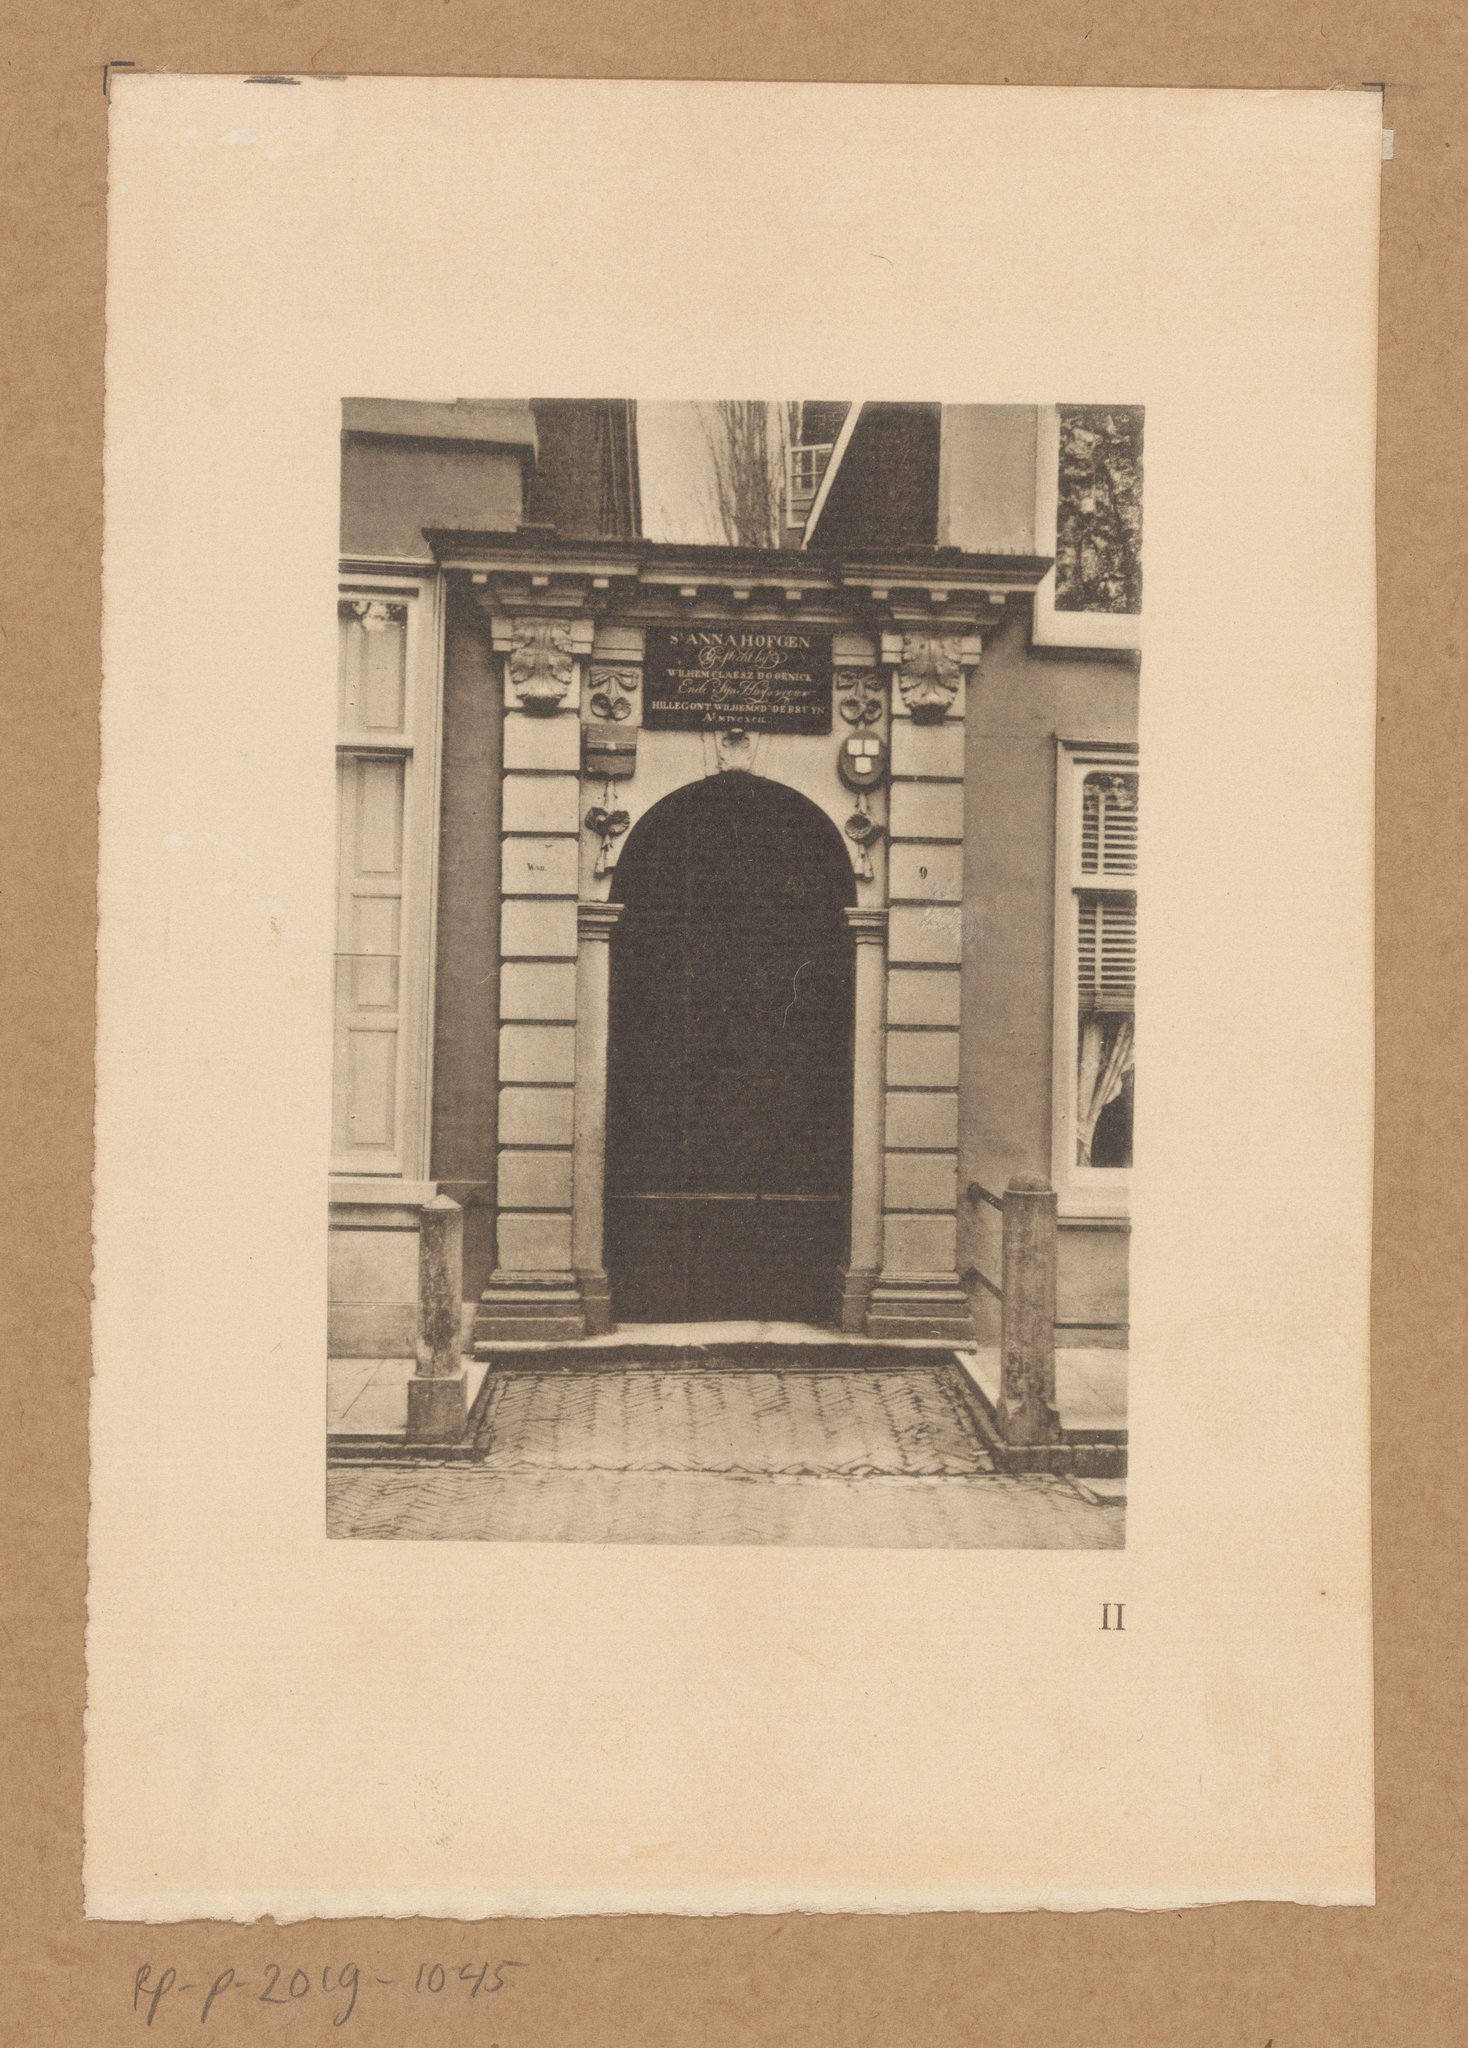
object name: photomechanical print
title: Gezicht op de poort van het Sint Annahofje te Leiden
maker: Anonymous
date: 1890-1910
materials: paper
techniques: photograph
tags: alms-house (dutch: 'hofje'), gate, entrance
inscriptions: collector's mark: Lugt 2228